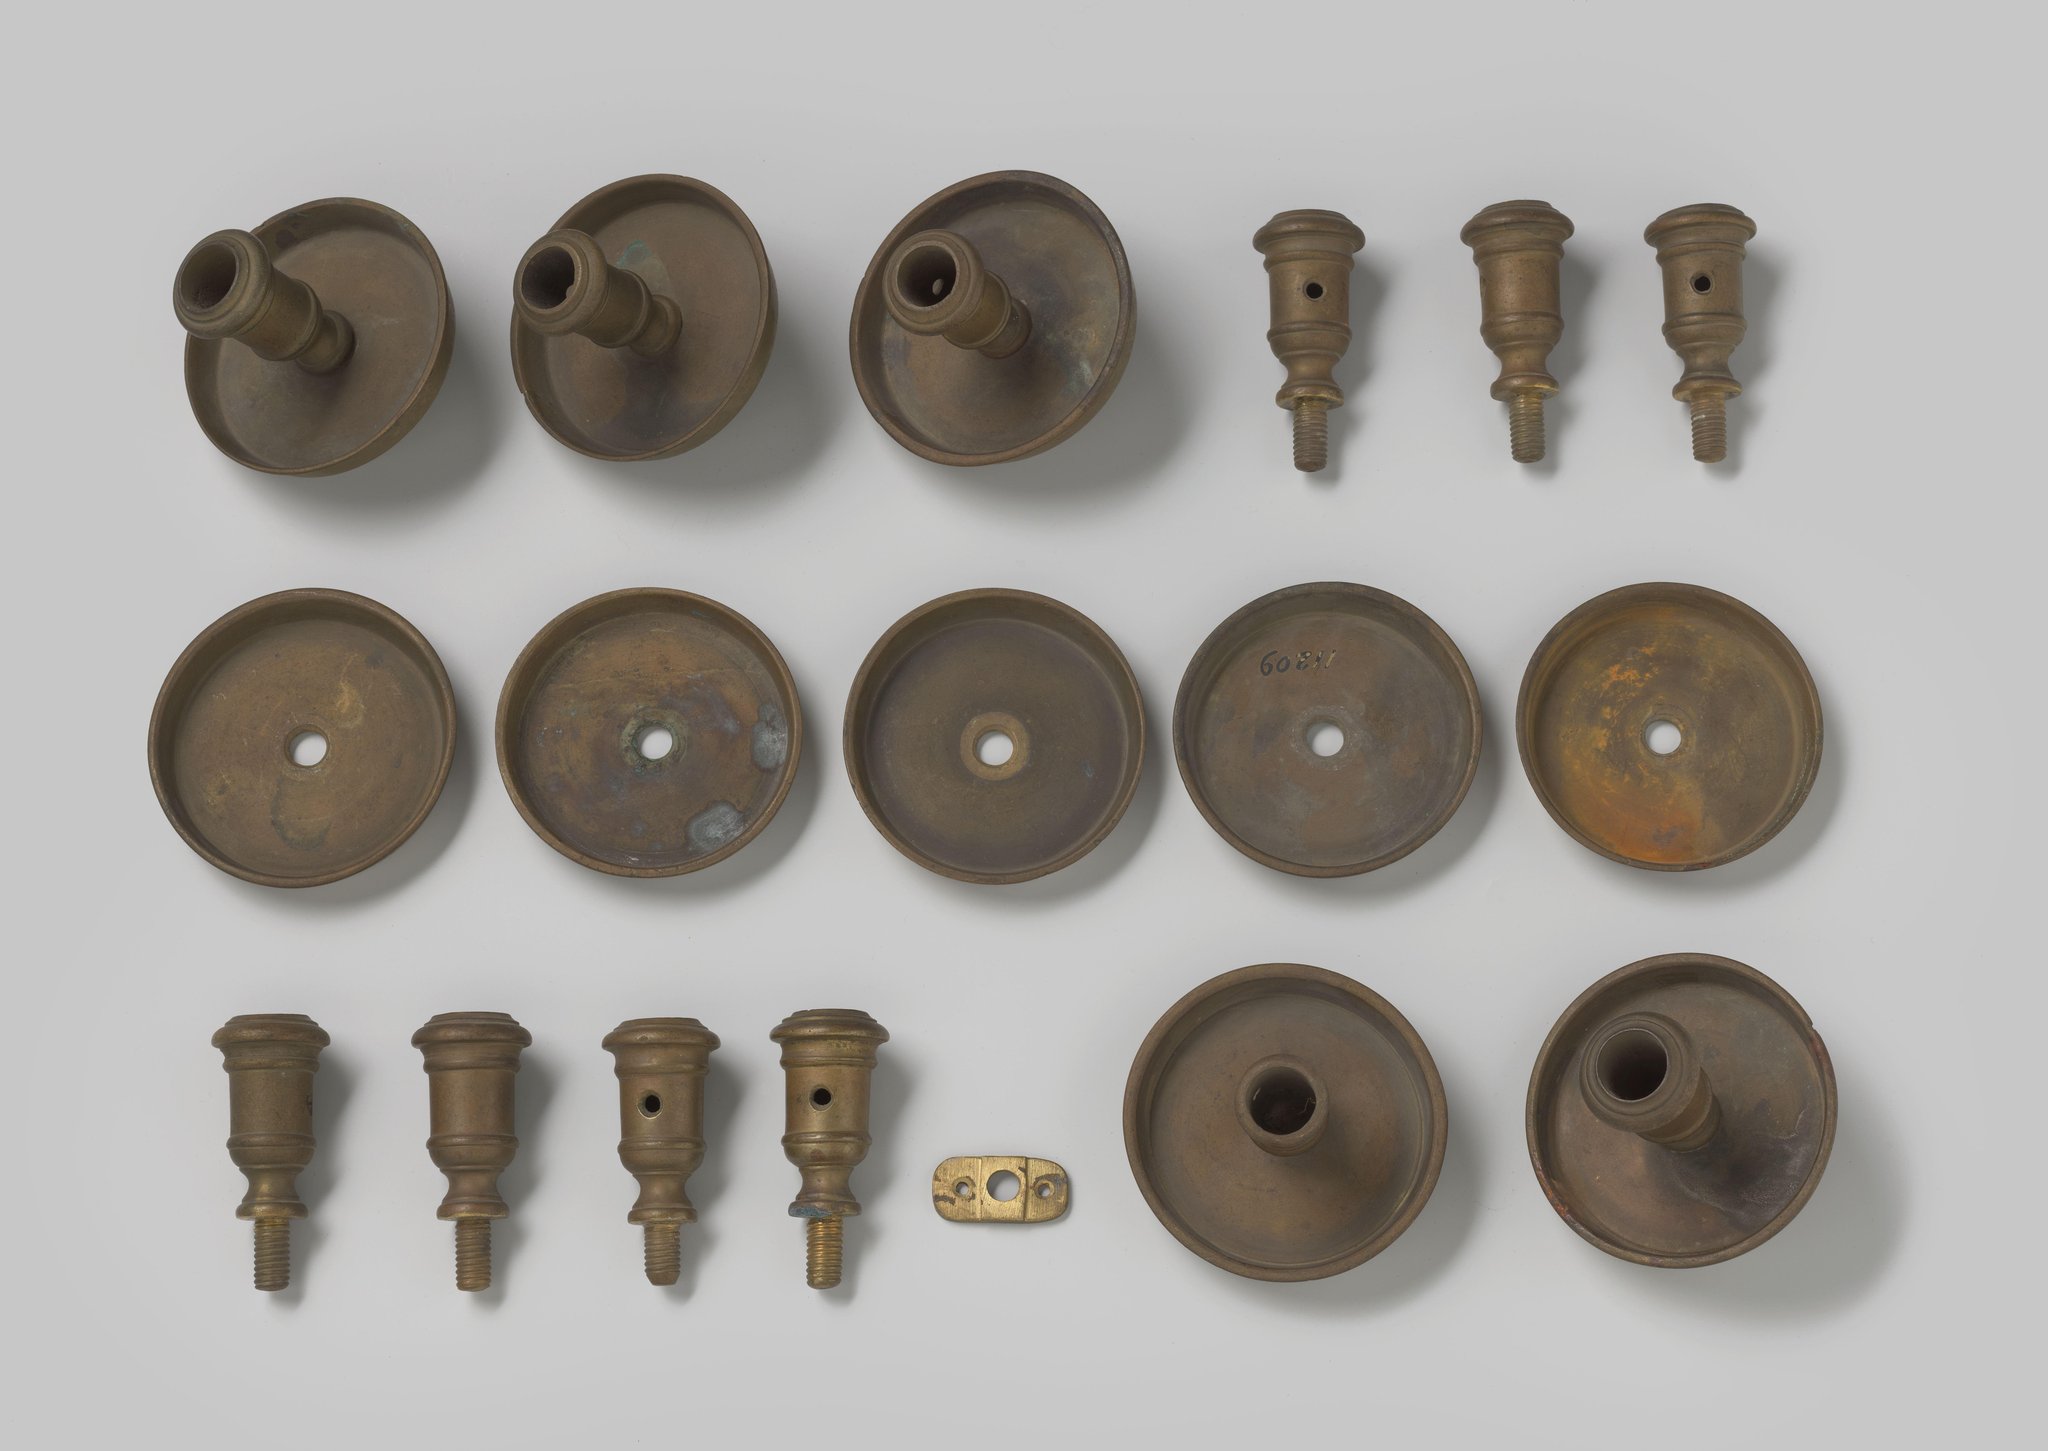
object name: bobeche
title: Achttien kaarsenhouders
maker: Anonymous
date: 1650-1750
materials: brass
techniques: casting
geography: netherlands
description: De geprofileerde cylindrische kaarsenhouder is in de wand voorzien van een rond gaatje. De ronde vetvanger heeft een platte, onversierde bodem. Van de achttien stellen, welke werden gekocht, zijn twaalf kaarsenhouders en tien vetvangers aanwezig. Negen kaarsenhouders hebben eenzelfde vorm, drie wijken iets af.